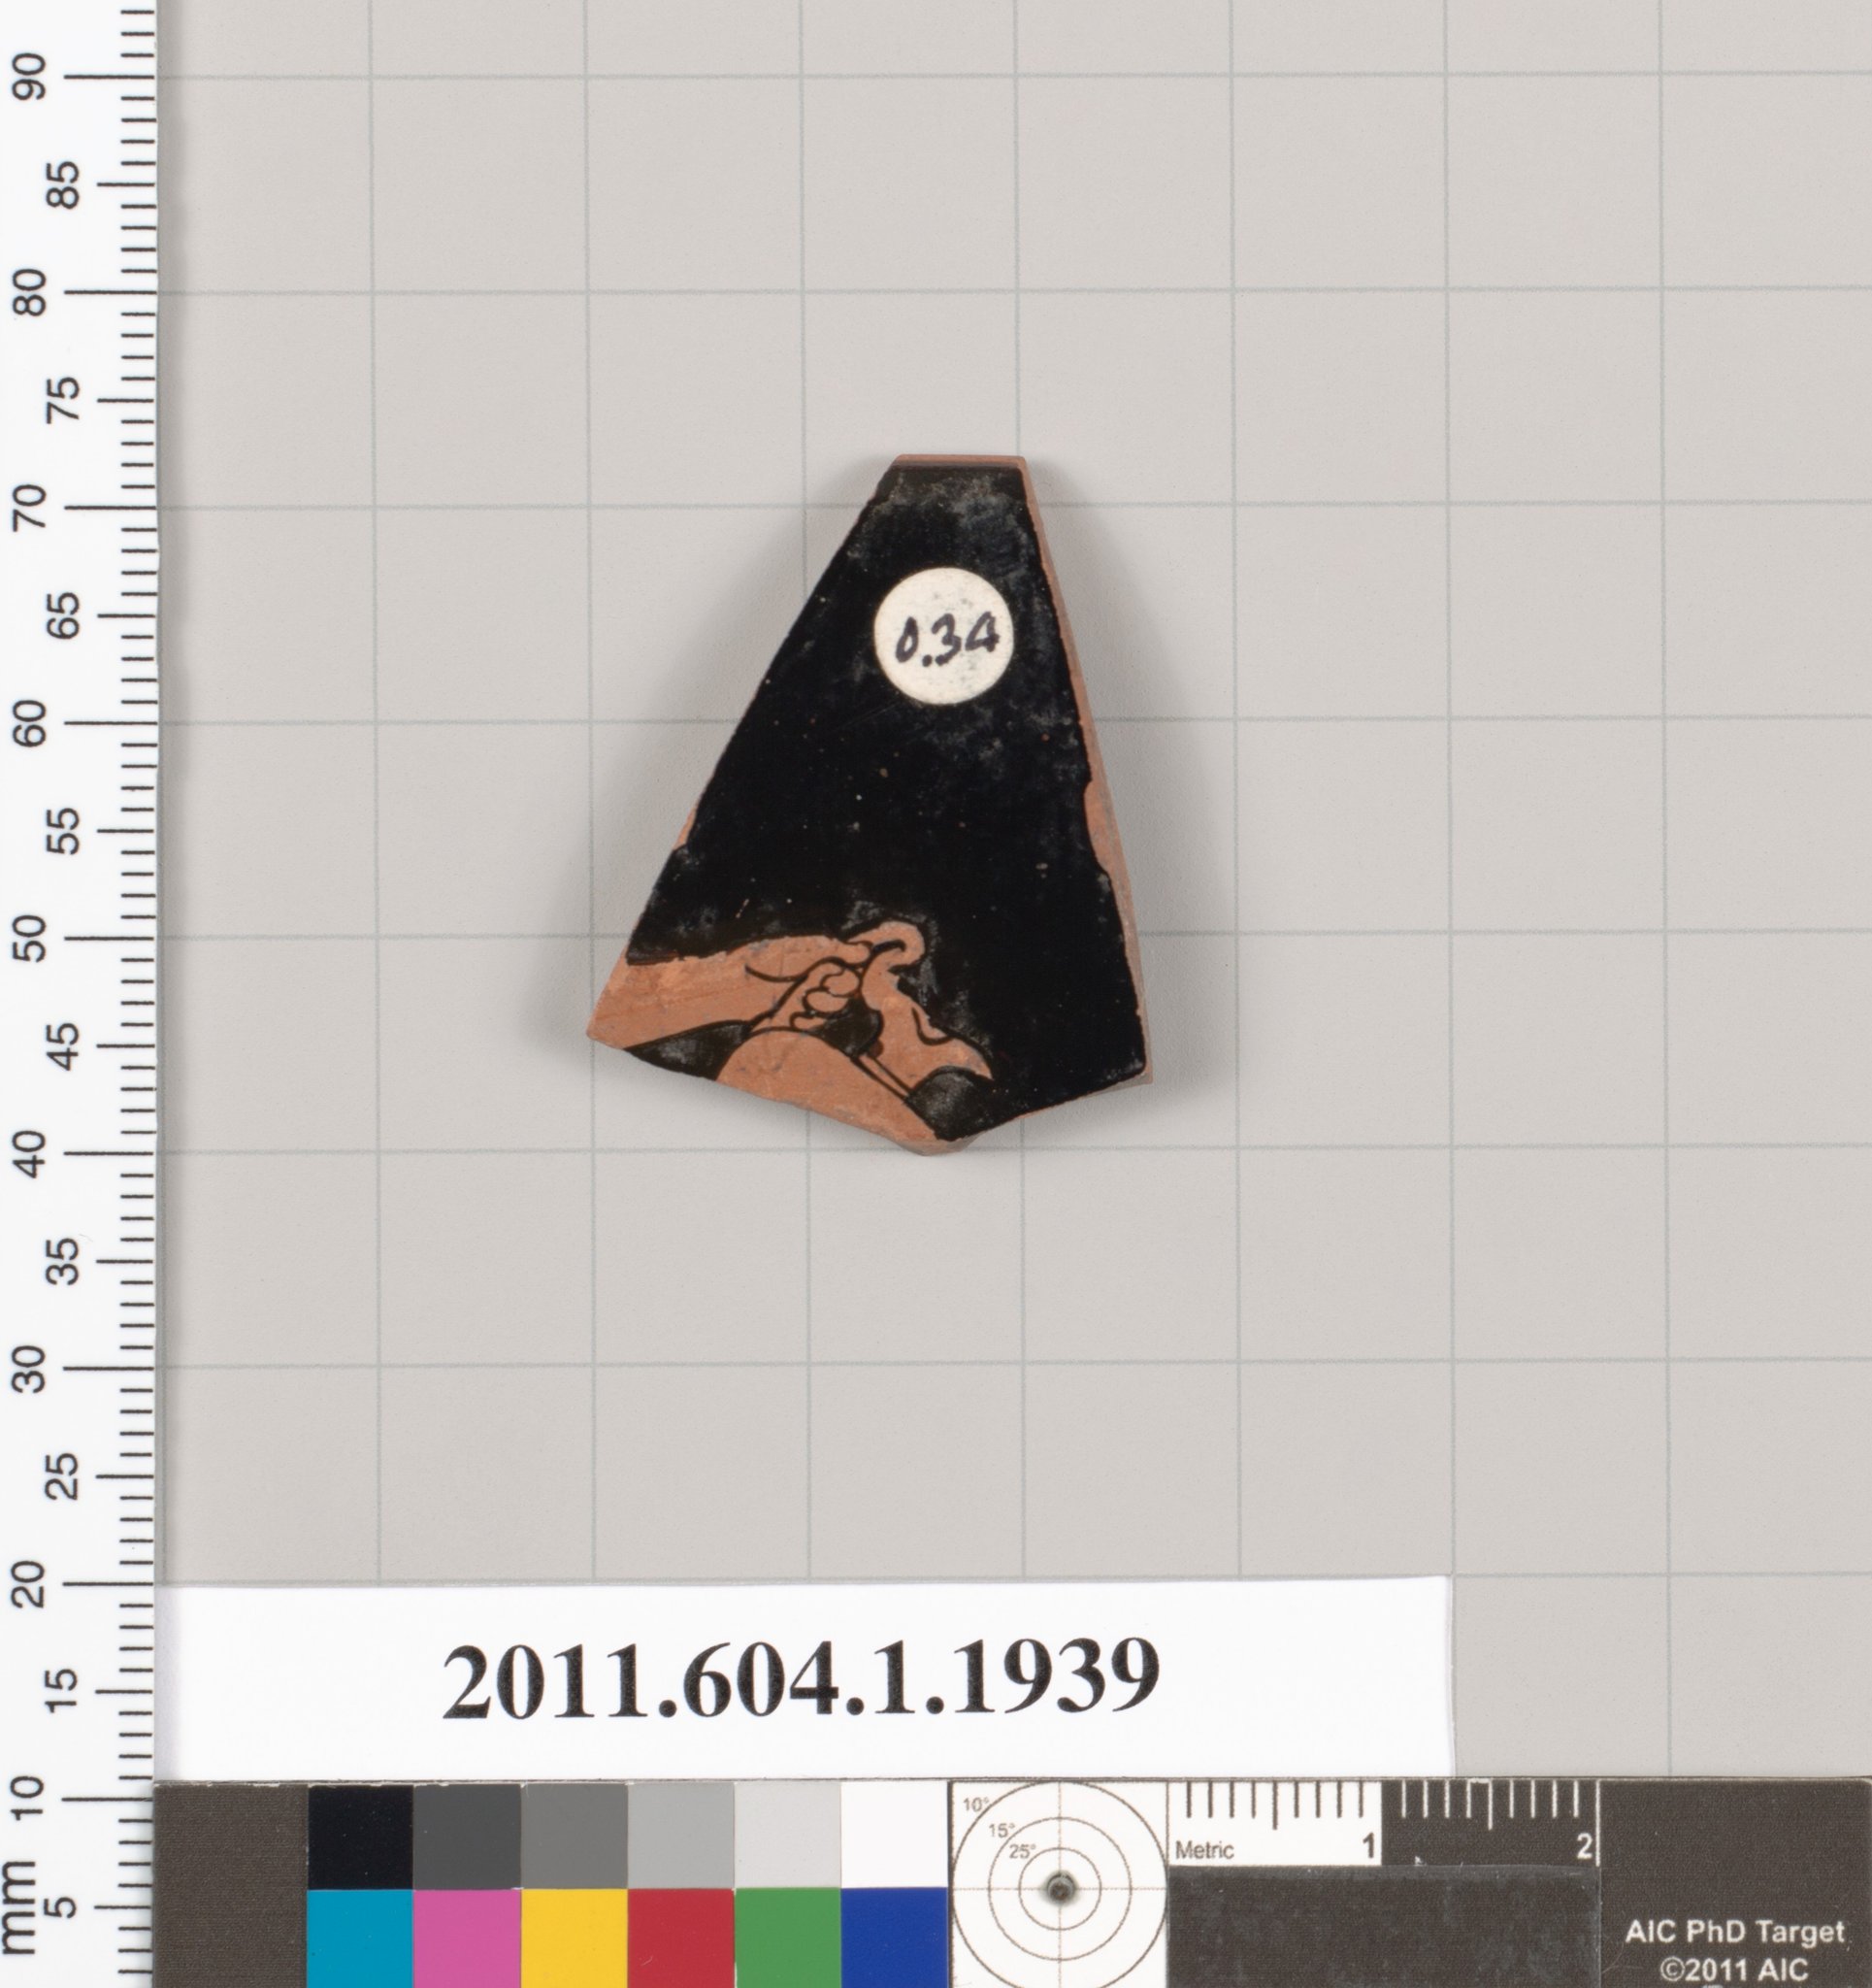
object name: kylix fragment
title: Terracotta rim fragment of a kylix (drinking cup)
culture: greek, attic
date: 490-480 BCE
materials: terracotta